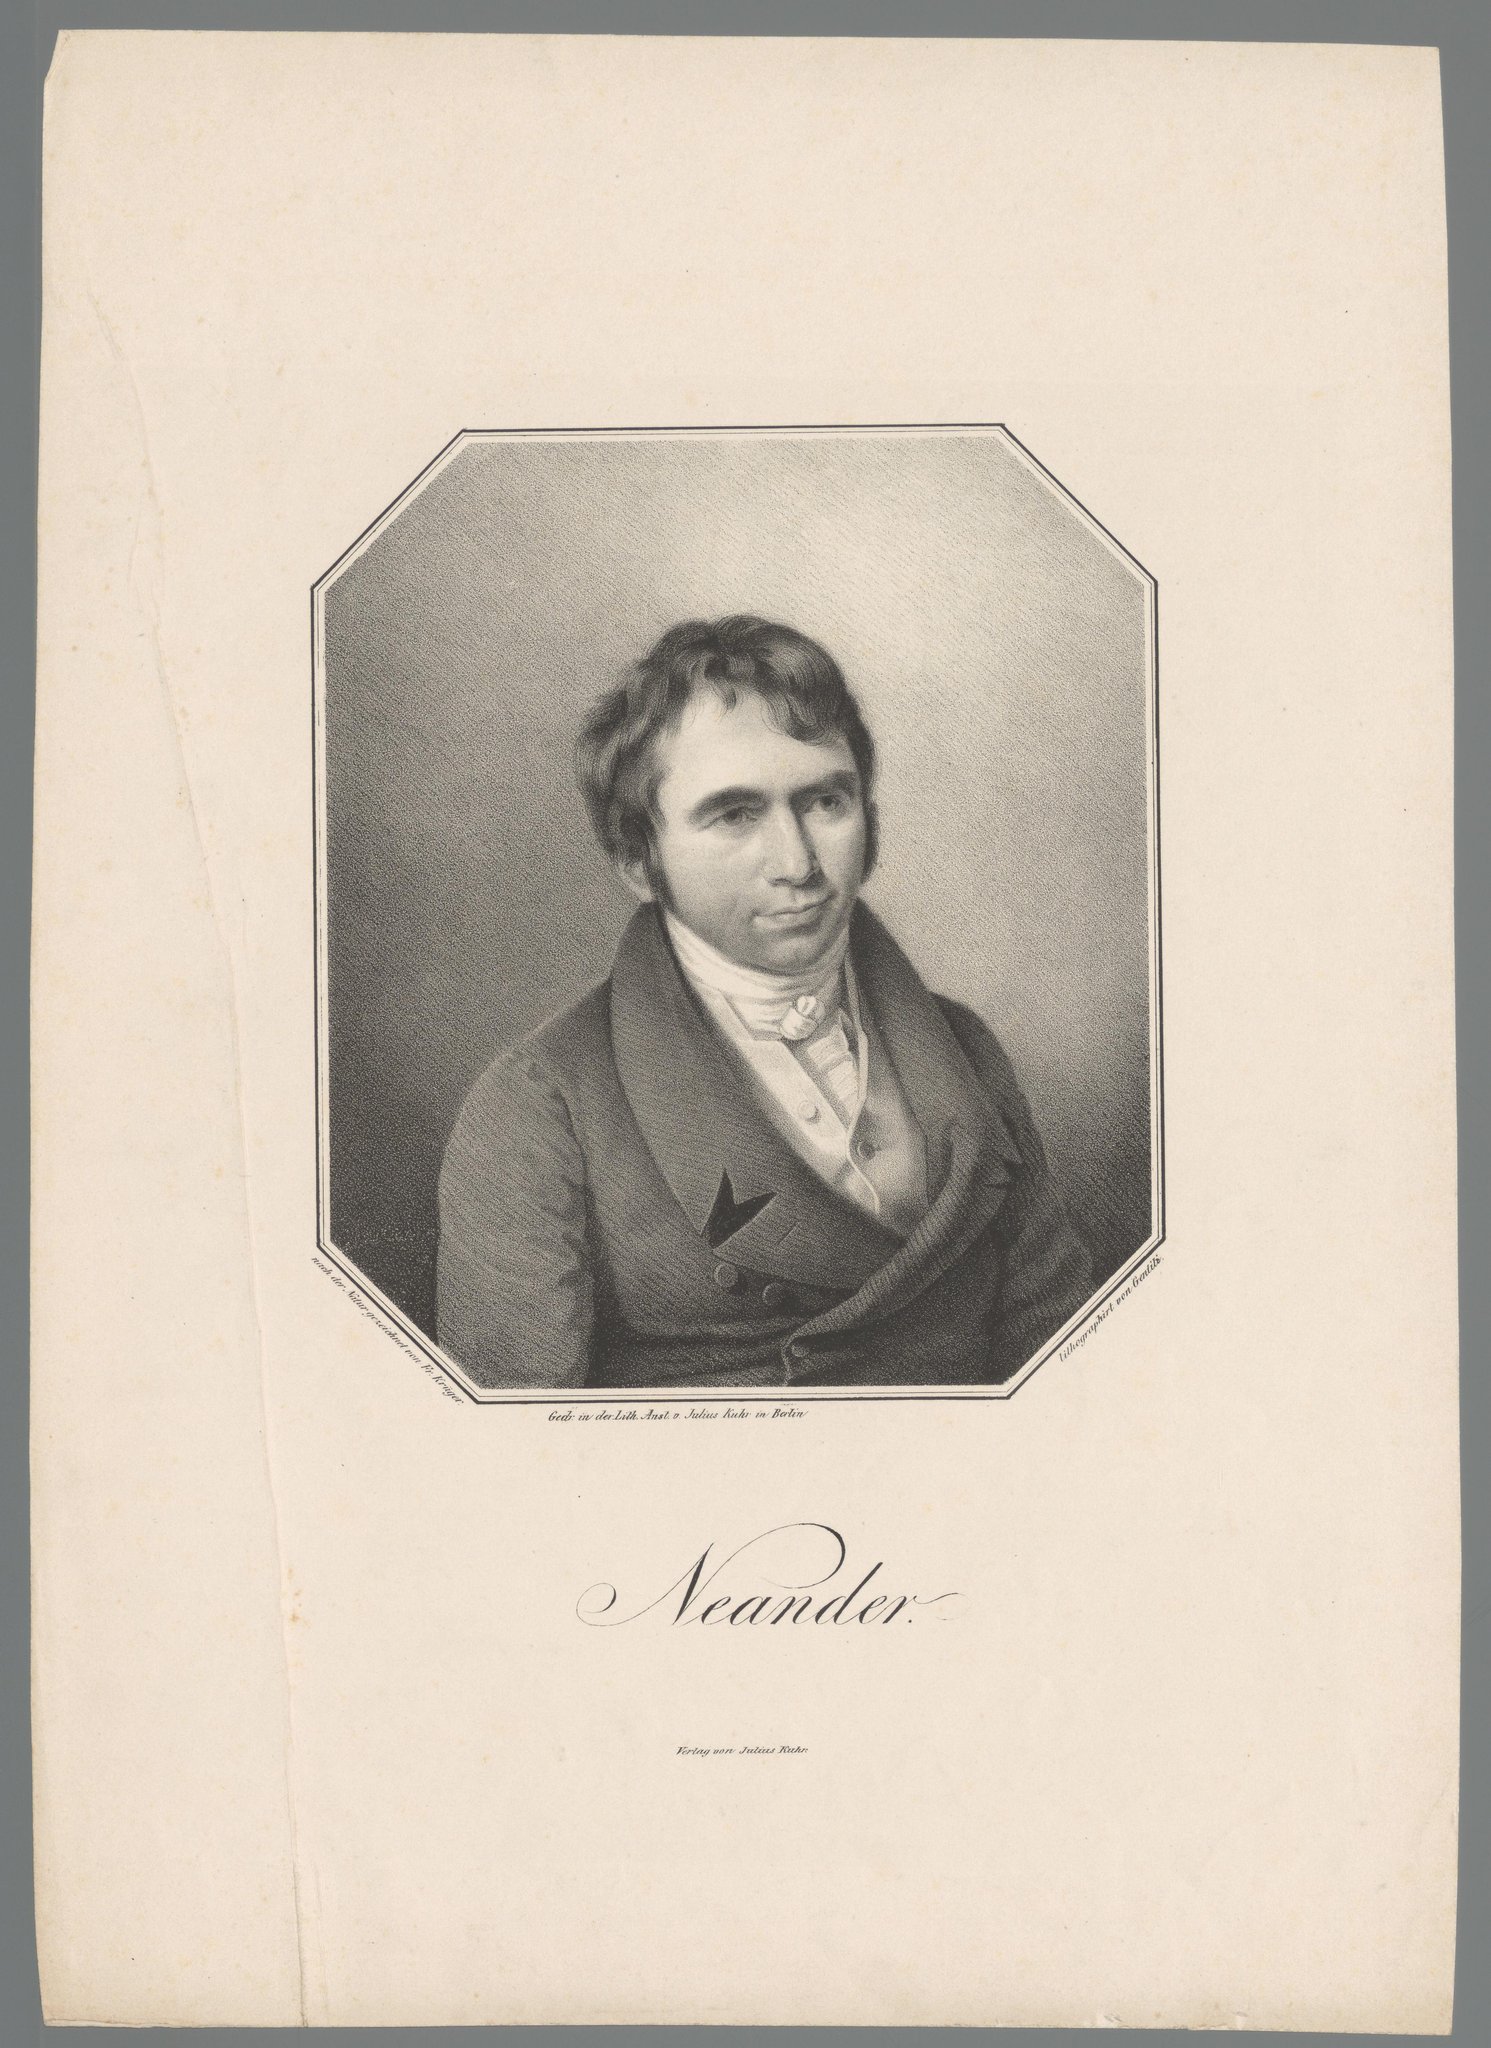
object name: print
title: Neander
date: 1820-1840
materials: paper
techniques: lithograph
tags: berlin, theologian, historical persons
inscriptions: collector's mark: Lugt 2228